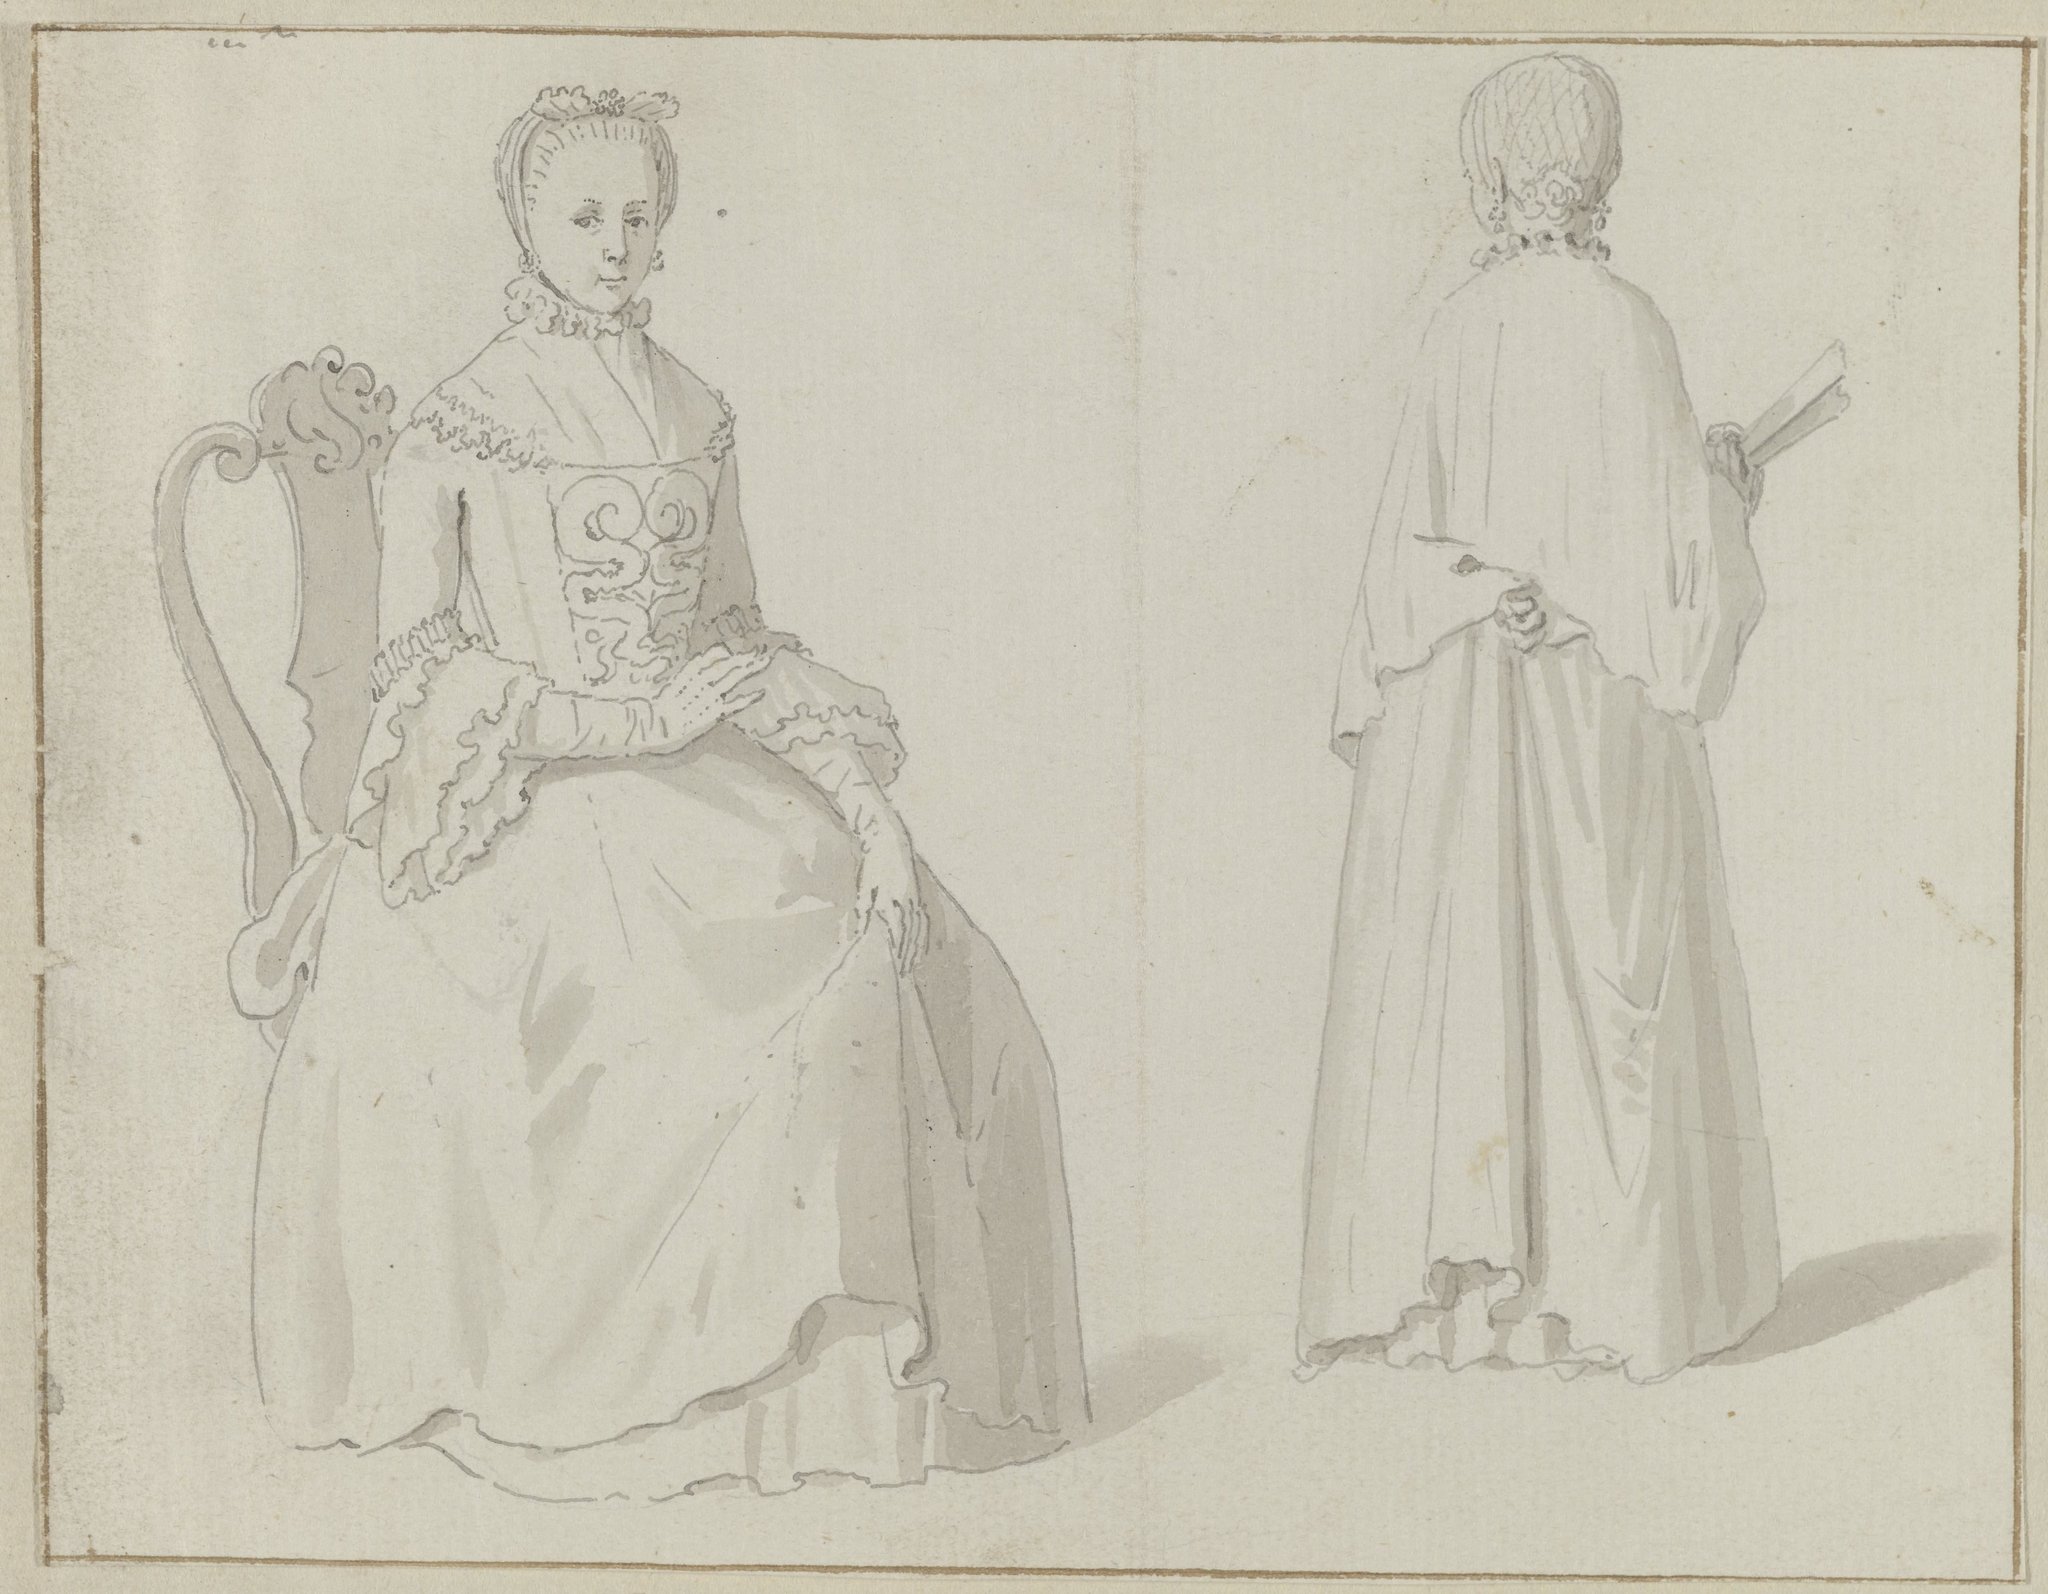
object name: drawing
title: Op stoel zittende vrouw en vrouw met waaier op de rug gezien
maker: Anonymous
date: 1700-1799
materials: ink, paper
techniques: brush, pen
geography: netherlands